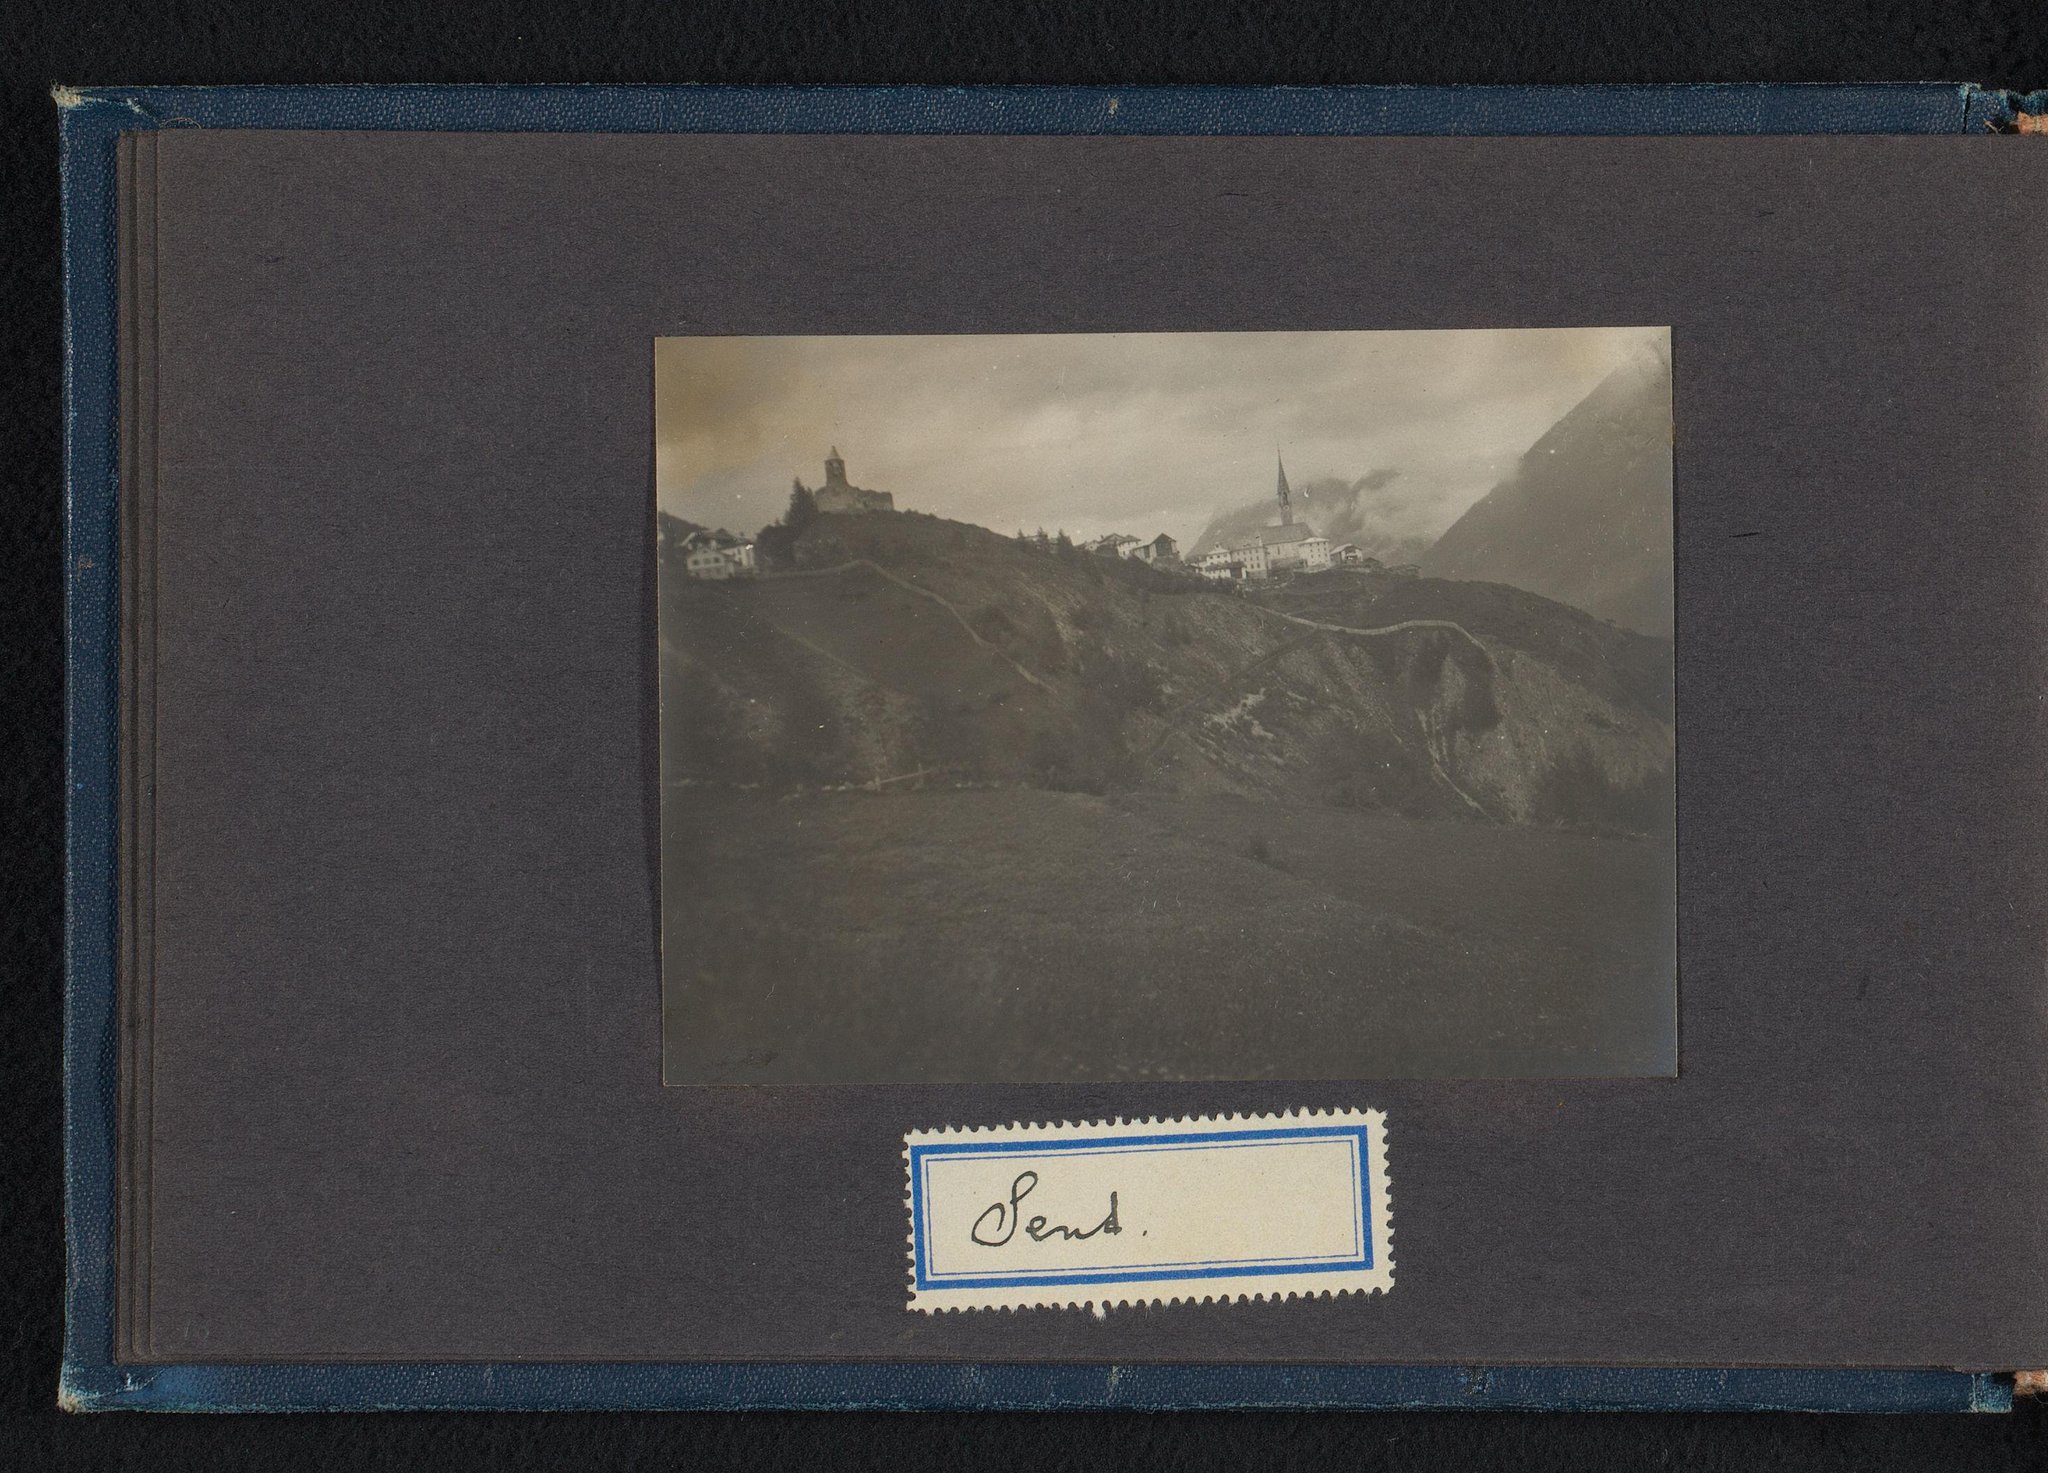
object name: album leaf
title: Sent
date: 1913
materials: paper, photographic support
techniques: gelatin silver print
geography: switzerland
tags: mountain-range, snow peaks, switzerland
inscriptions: inscription: ‘Sent’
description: Albumblad met een foto van het dorp Sent, Zwitserland. Onderdeel van het fotoalbum van Else Wachenheimer-Moos en haar broers Arthur en Willy Moos en anderen in de periode 1913-1918.